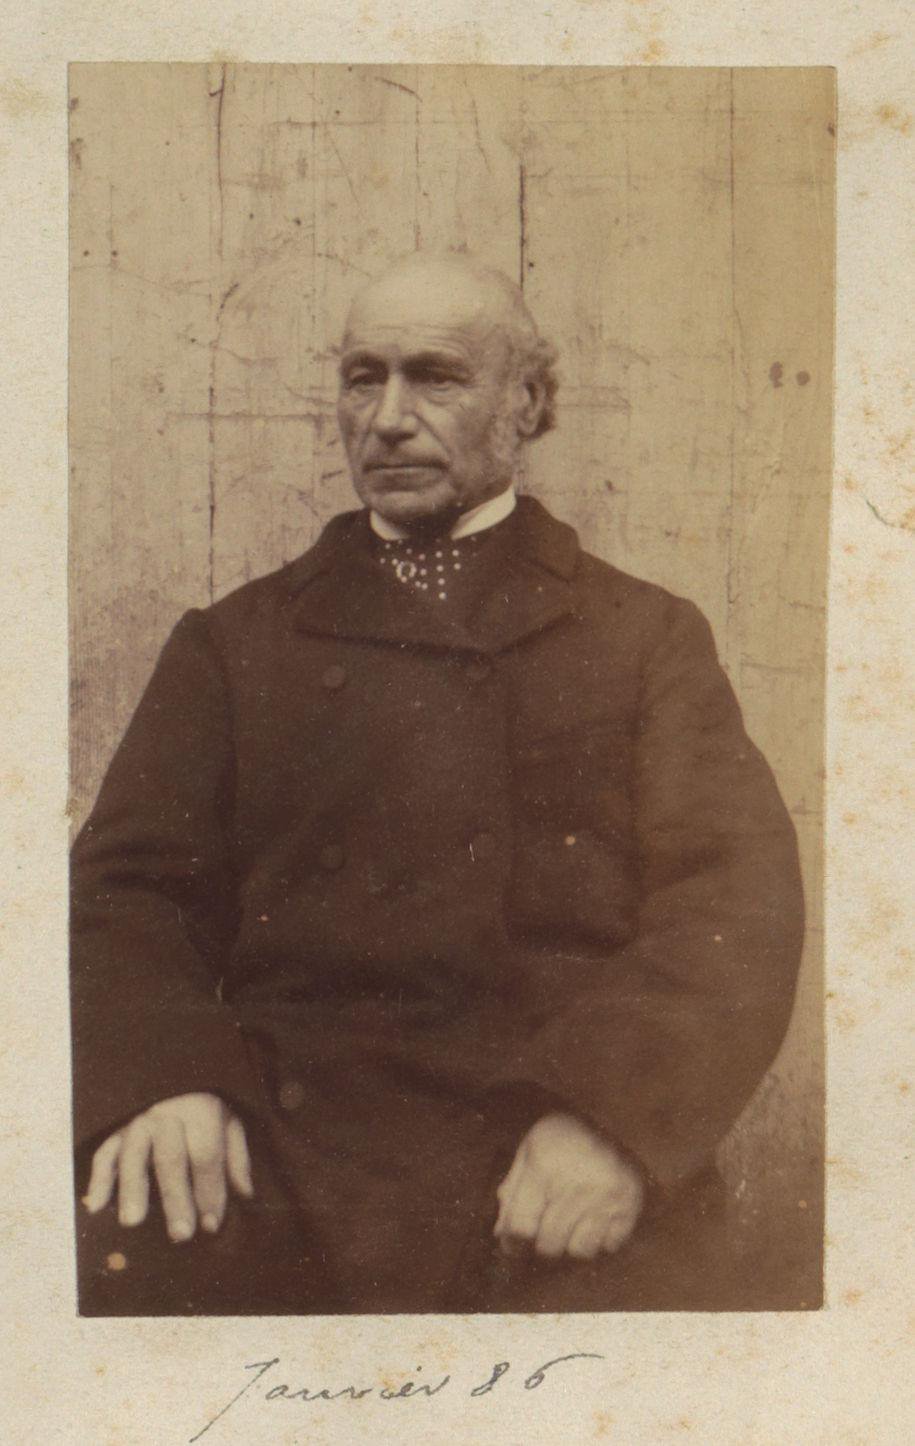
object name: photograph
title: Portret van een Fransman, aangeduid als 'papa Choux'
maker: Anonymous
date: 1801-1886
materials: photographic support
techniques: albumen print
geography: france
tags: adult man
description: Onderdeel van Album van een Franse amateurfotograaf met opnames van familie, militairen, industrie, landschappen en bezienswaardigheden in Frankrijk.